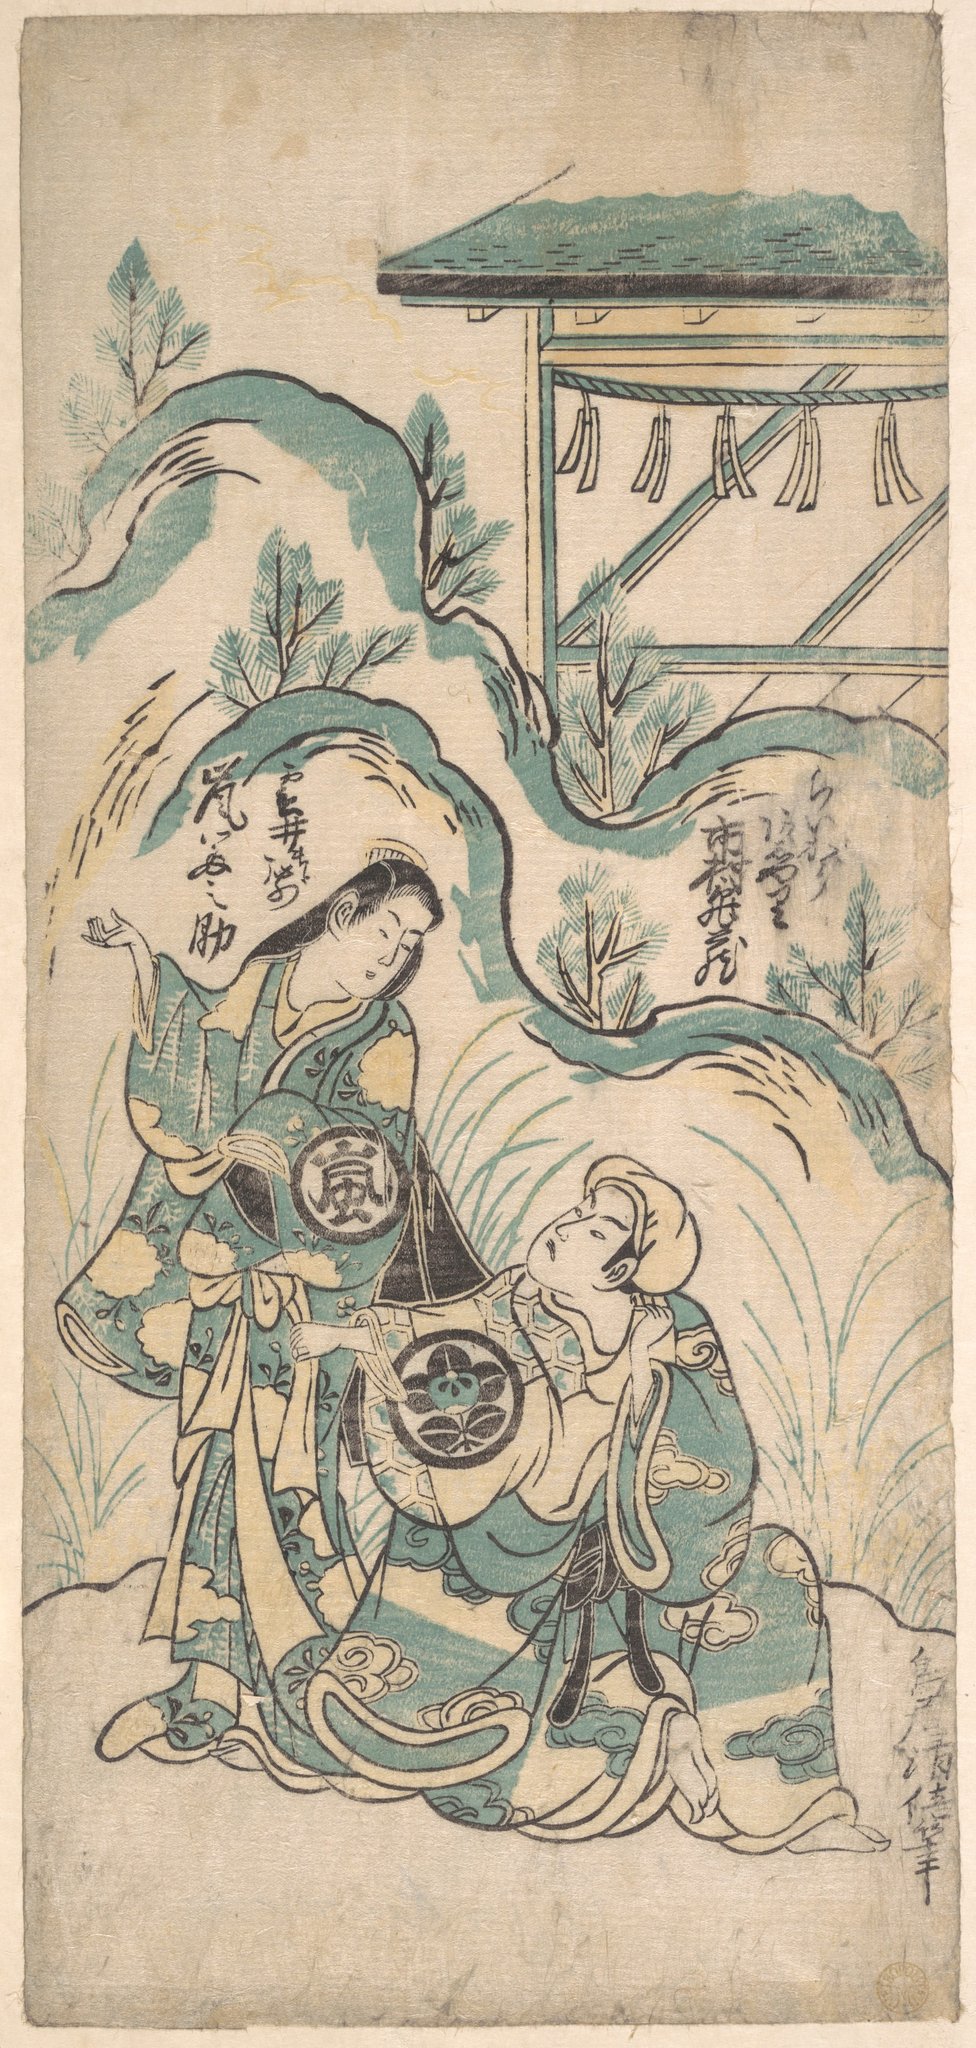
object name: print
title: Ichimura Kamezo and Arashi Tomonosuke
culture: japanese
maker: torii kiyomasu i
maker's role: artist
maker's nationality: japanese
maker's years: 1696-1716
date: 1748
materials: ink, paper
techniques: woodblock print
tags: men,women,actors